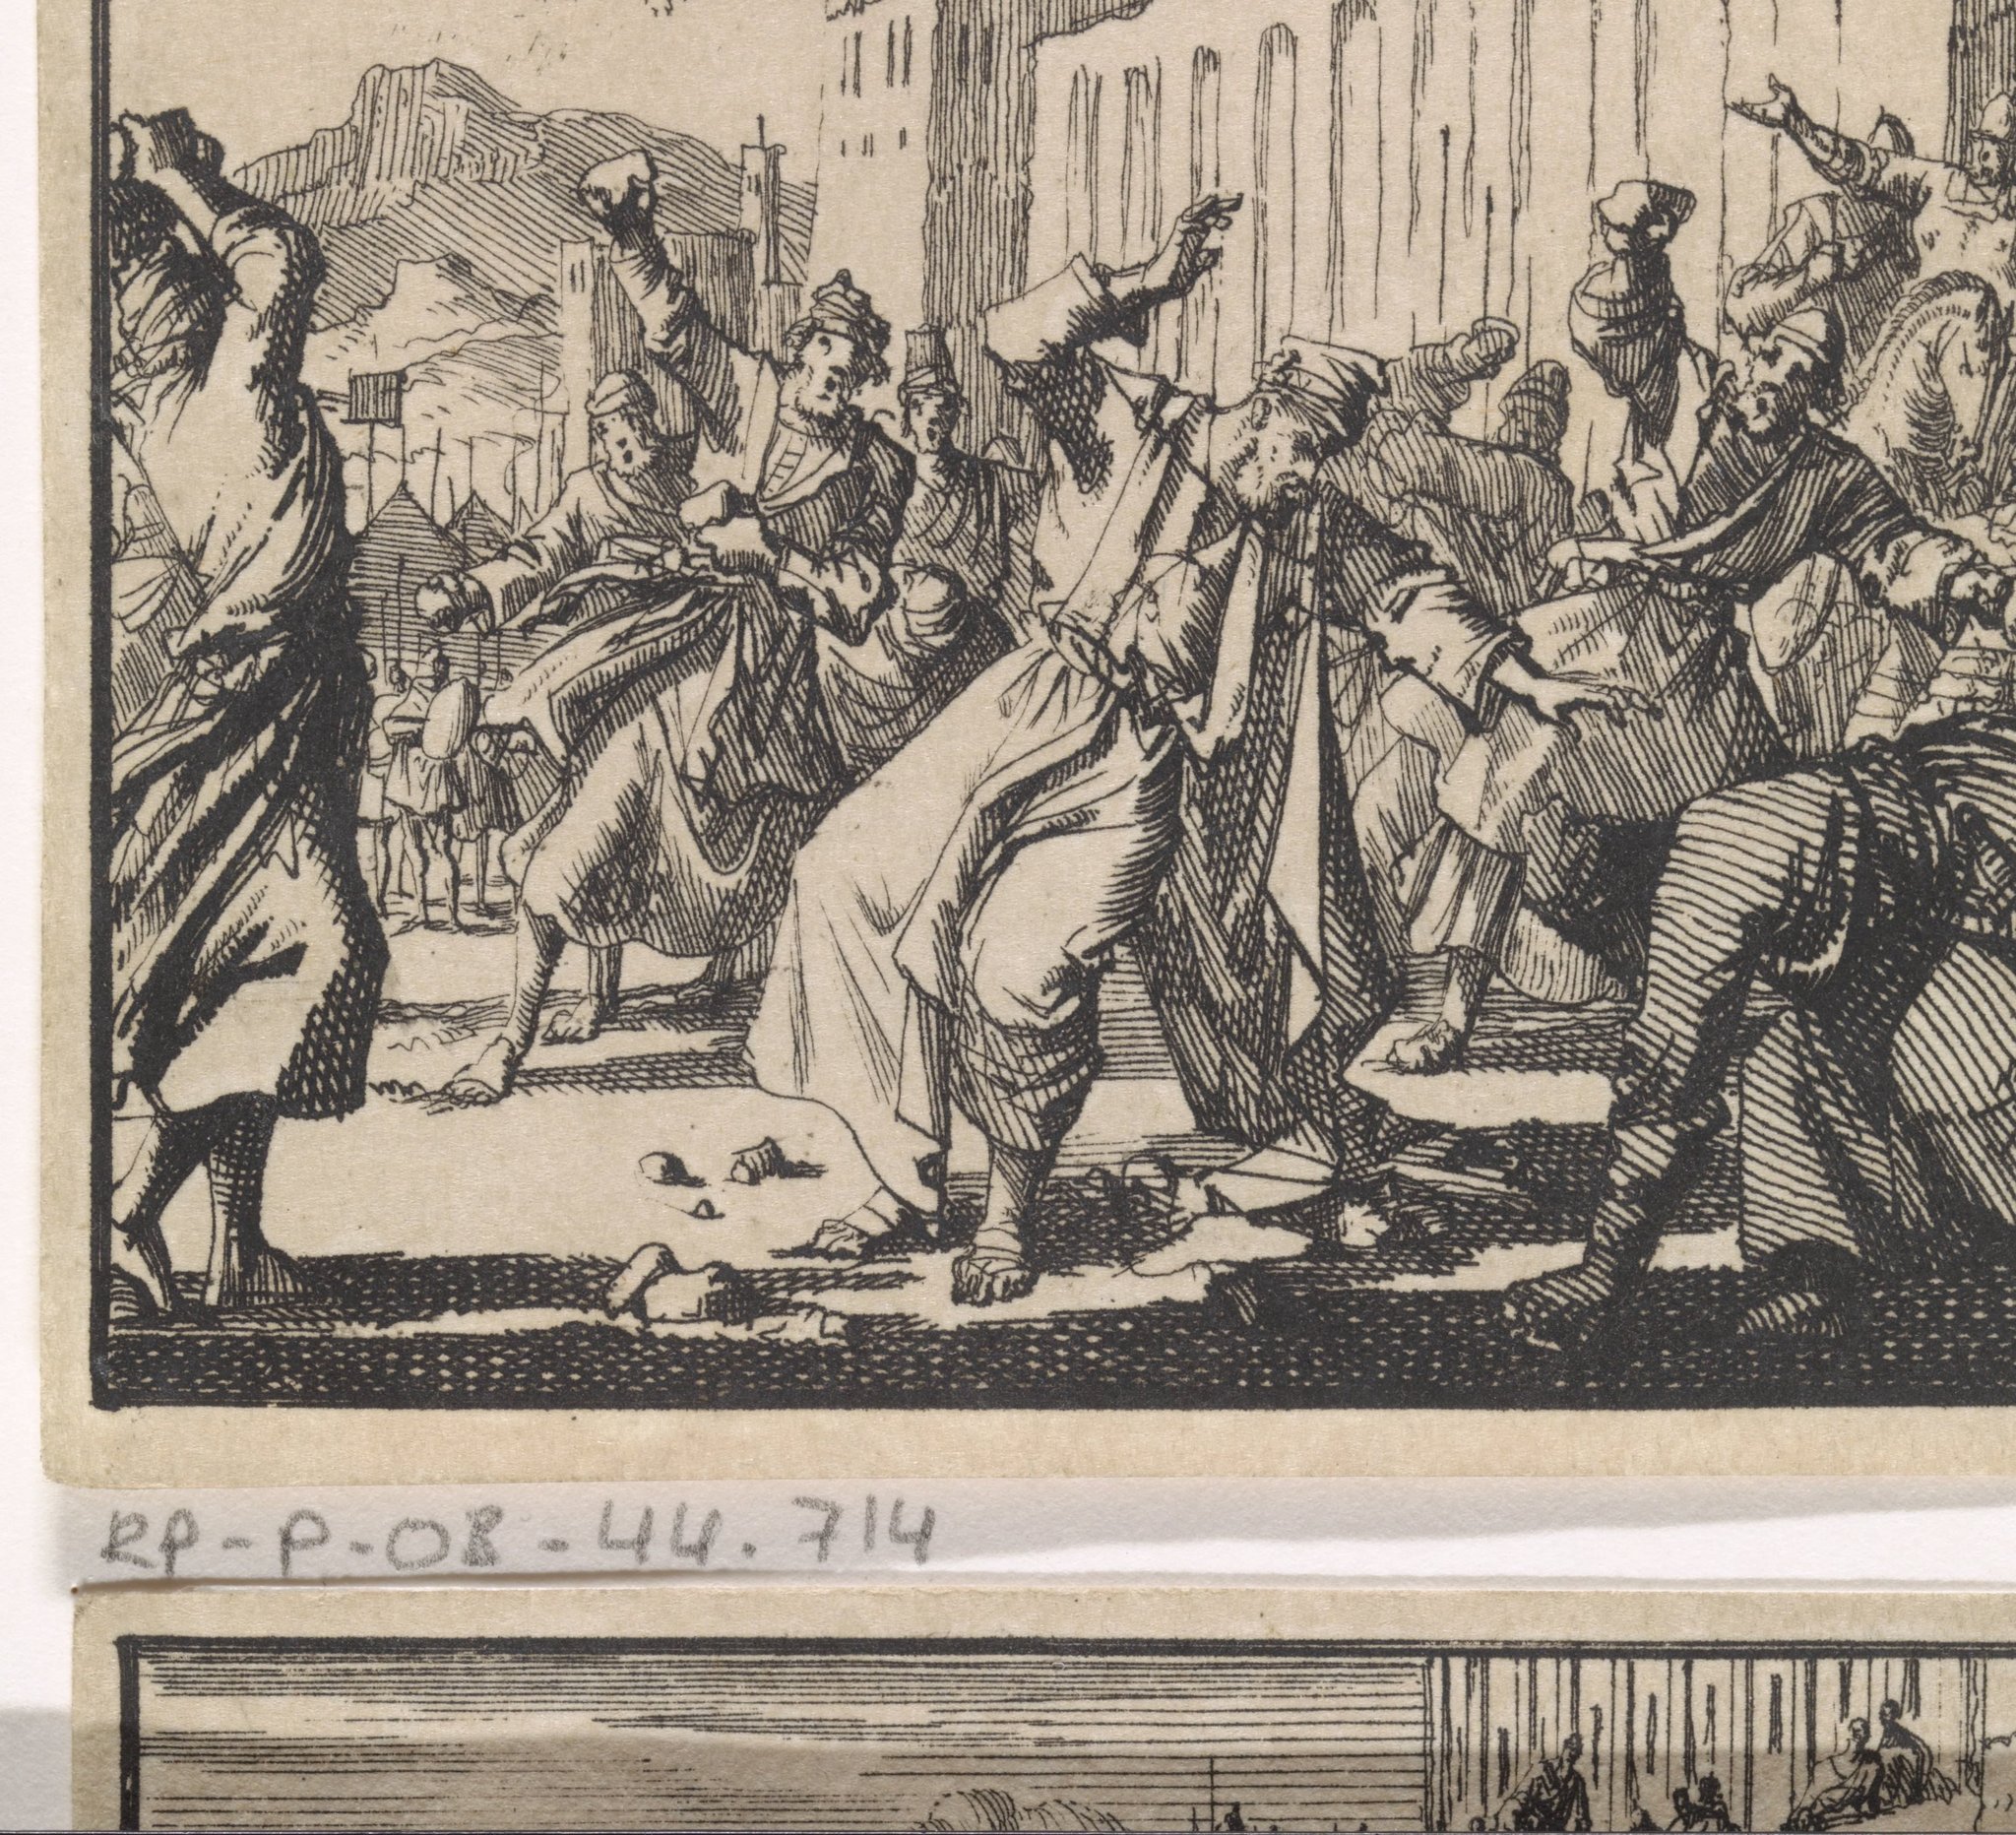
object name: print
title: Onias door het volk te Jeruzalem gestenigd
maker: jan luyken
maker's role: draughtsman, print maker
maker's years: 1649-1712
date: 1698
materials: paper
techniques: etching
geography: amsterdam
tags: onias, the high priest, is slandered (2 maccabees 4:1-4, 4:34-38)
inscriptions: collector's mark: Lugt 2228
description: Proefdruk van illustratie uit: Josephus, Flavius. XX. boeken van de oude geschiedenissen der joden, 4 delen. Amsterdam: Barent Visscher, Willem de Coup, Willem van Lamsveld, Andries van Damme, 1698, dl. II.